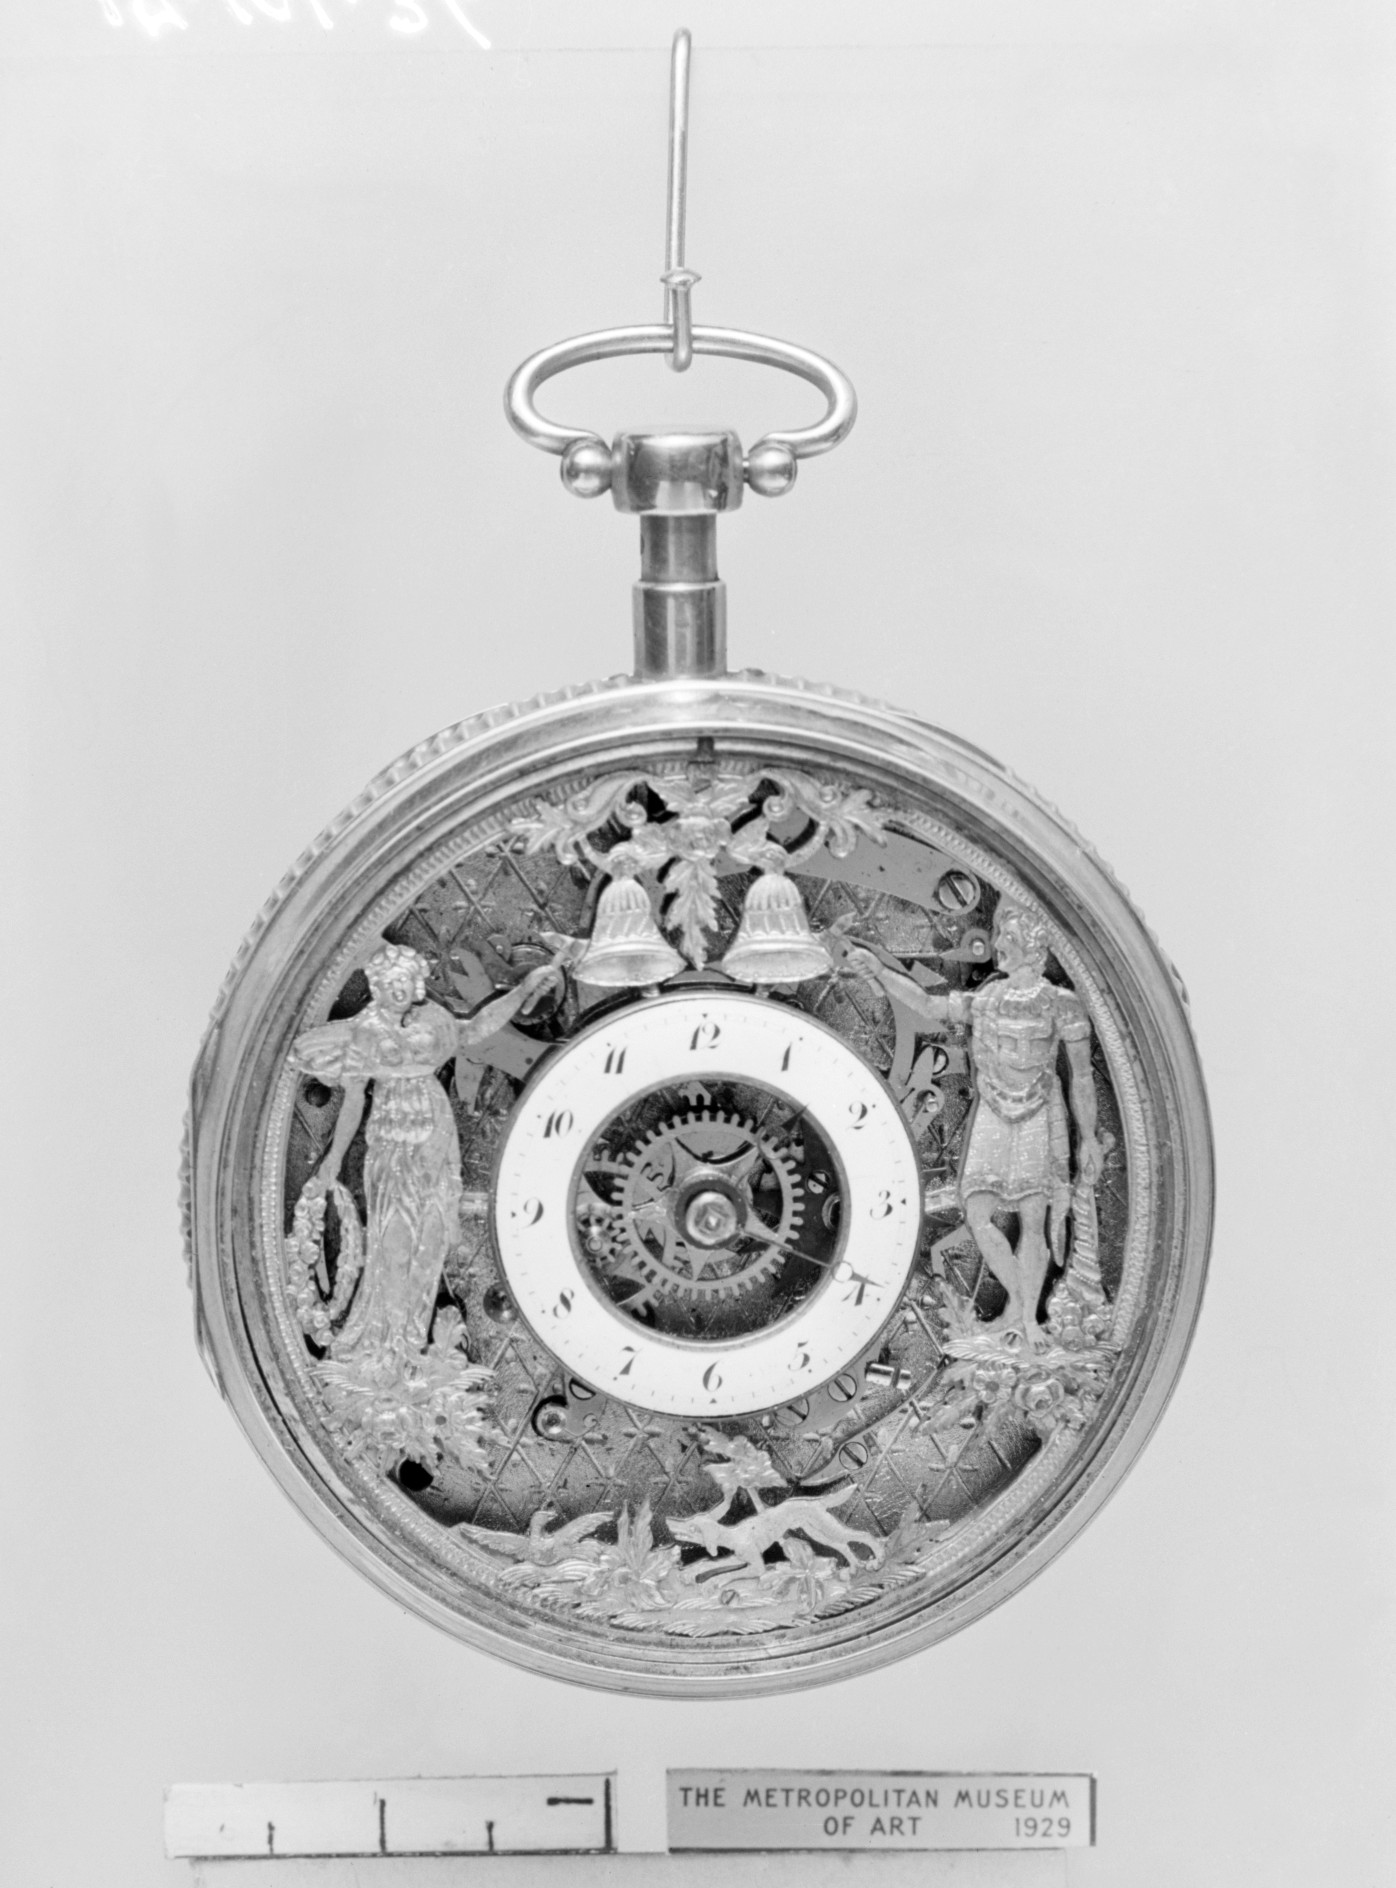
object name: repeating watch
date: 1801-1833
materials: gold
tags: birds,men,women,dogs,bells